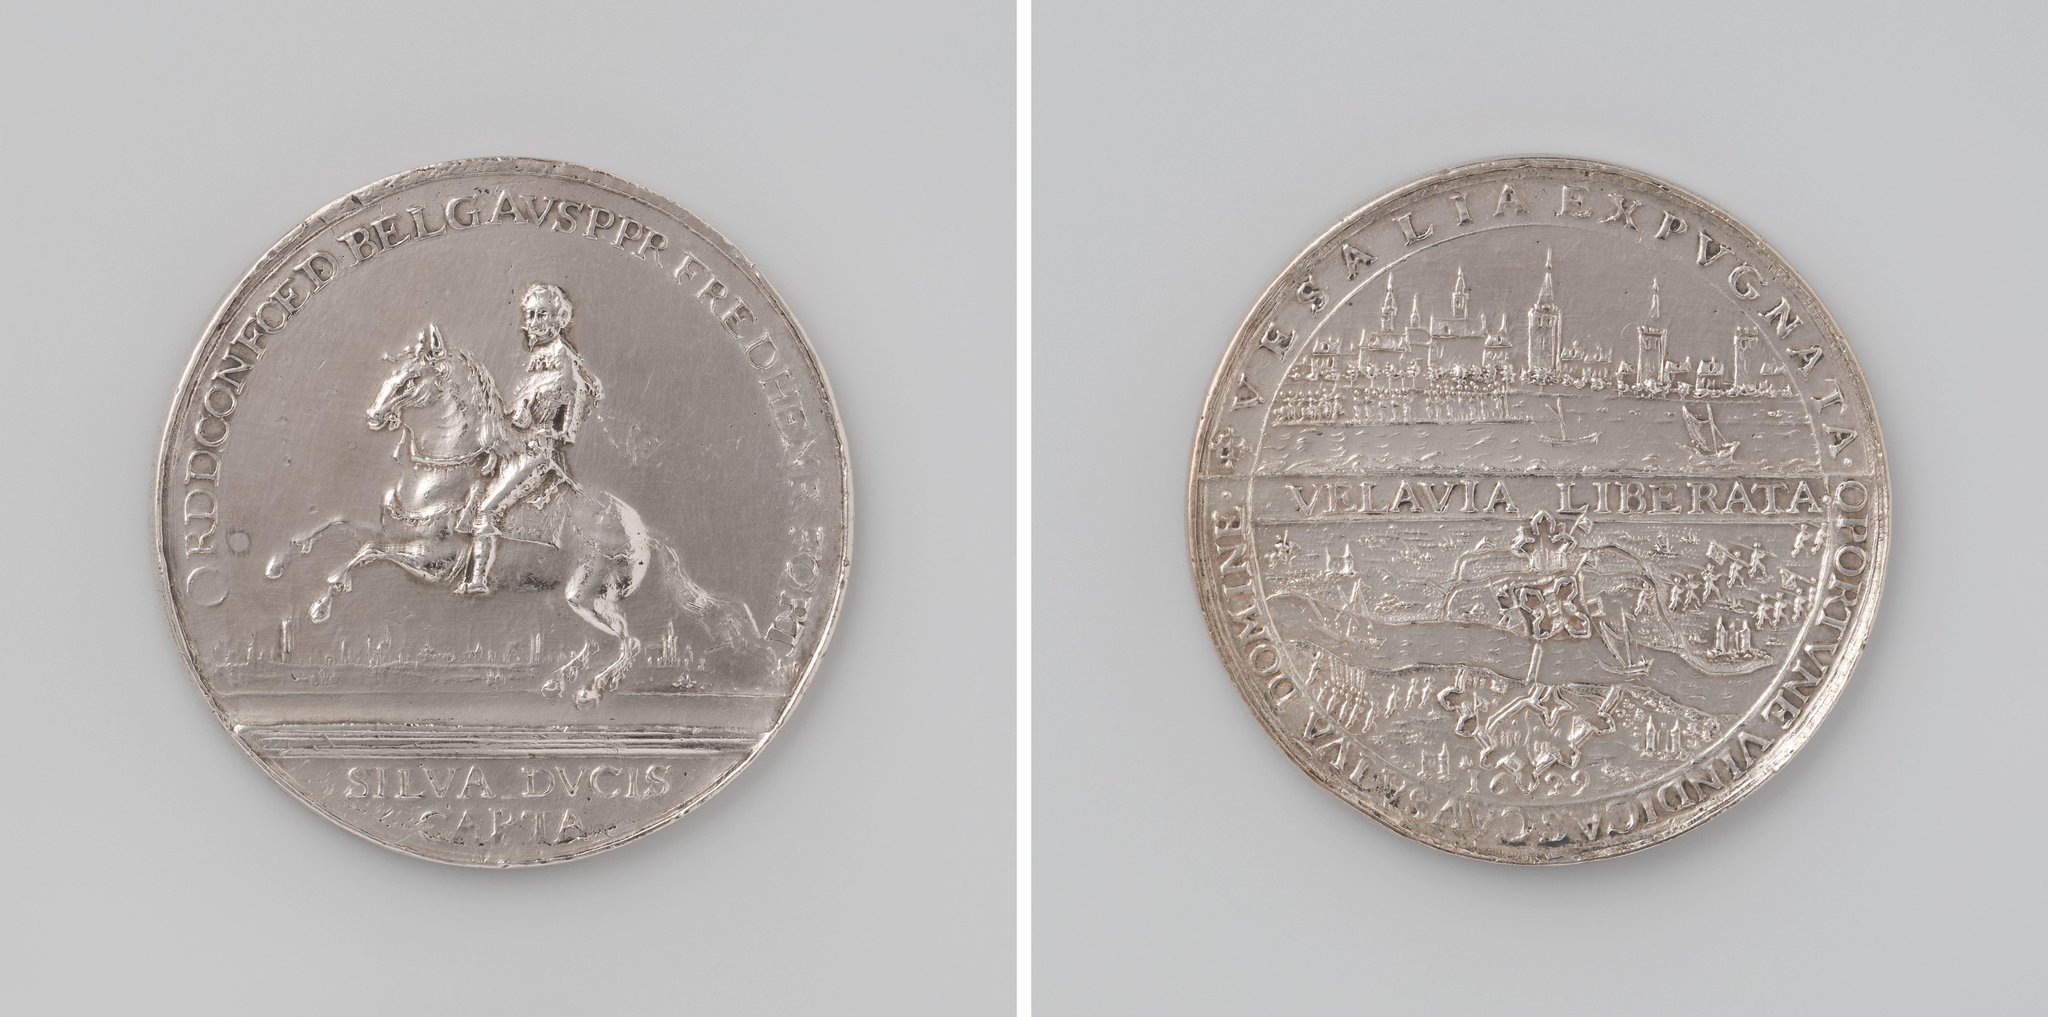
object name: triomfpenning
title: Inname van Den Bosch en Wezel door Frederik Hendrik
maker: willem versteech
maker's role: die cutter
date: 1629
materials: silver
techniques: striking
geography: harderwijk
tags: delft, the hague, frederick henry (prince of orange), den bosch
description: Zilveren penning. Voorzijde: man te paard; op achtergrond gezicht op stad Den Bosch binnen omschrift. Keerzijde:, boven: stad Wezel aan rivier, beneden: plattegrond van stad aan rivier, van elkaar gescheiden door opschrift, binnen omschrift